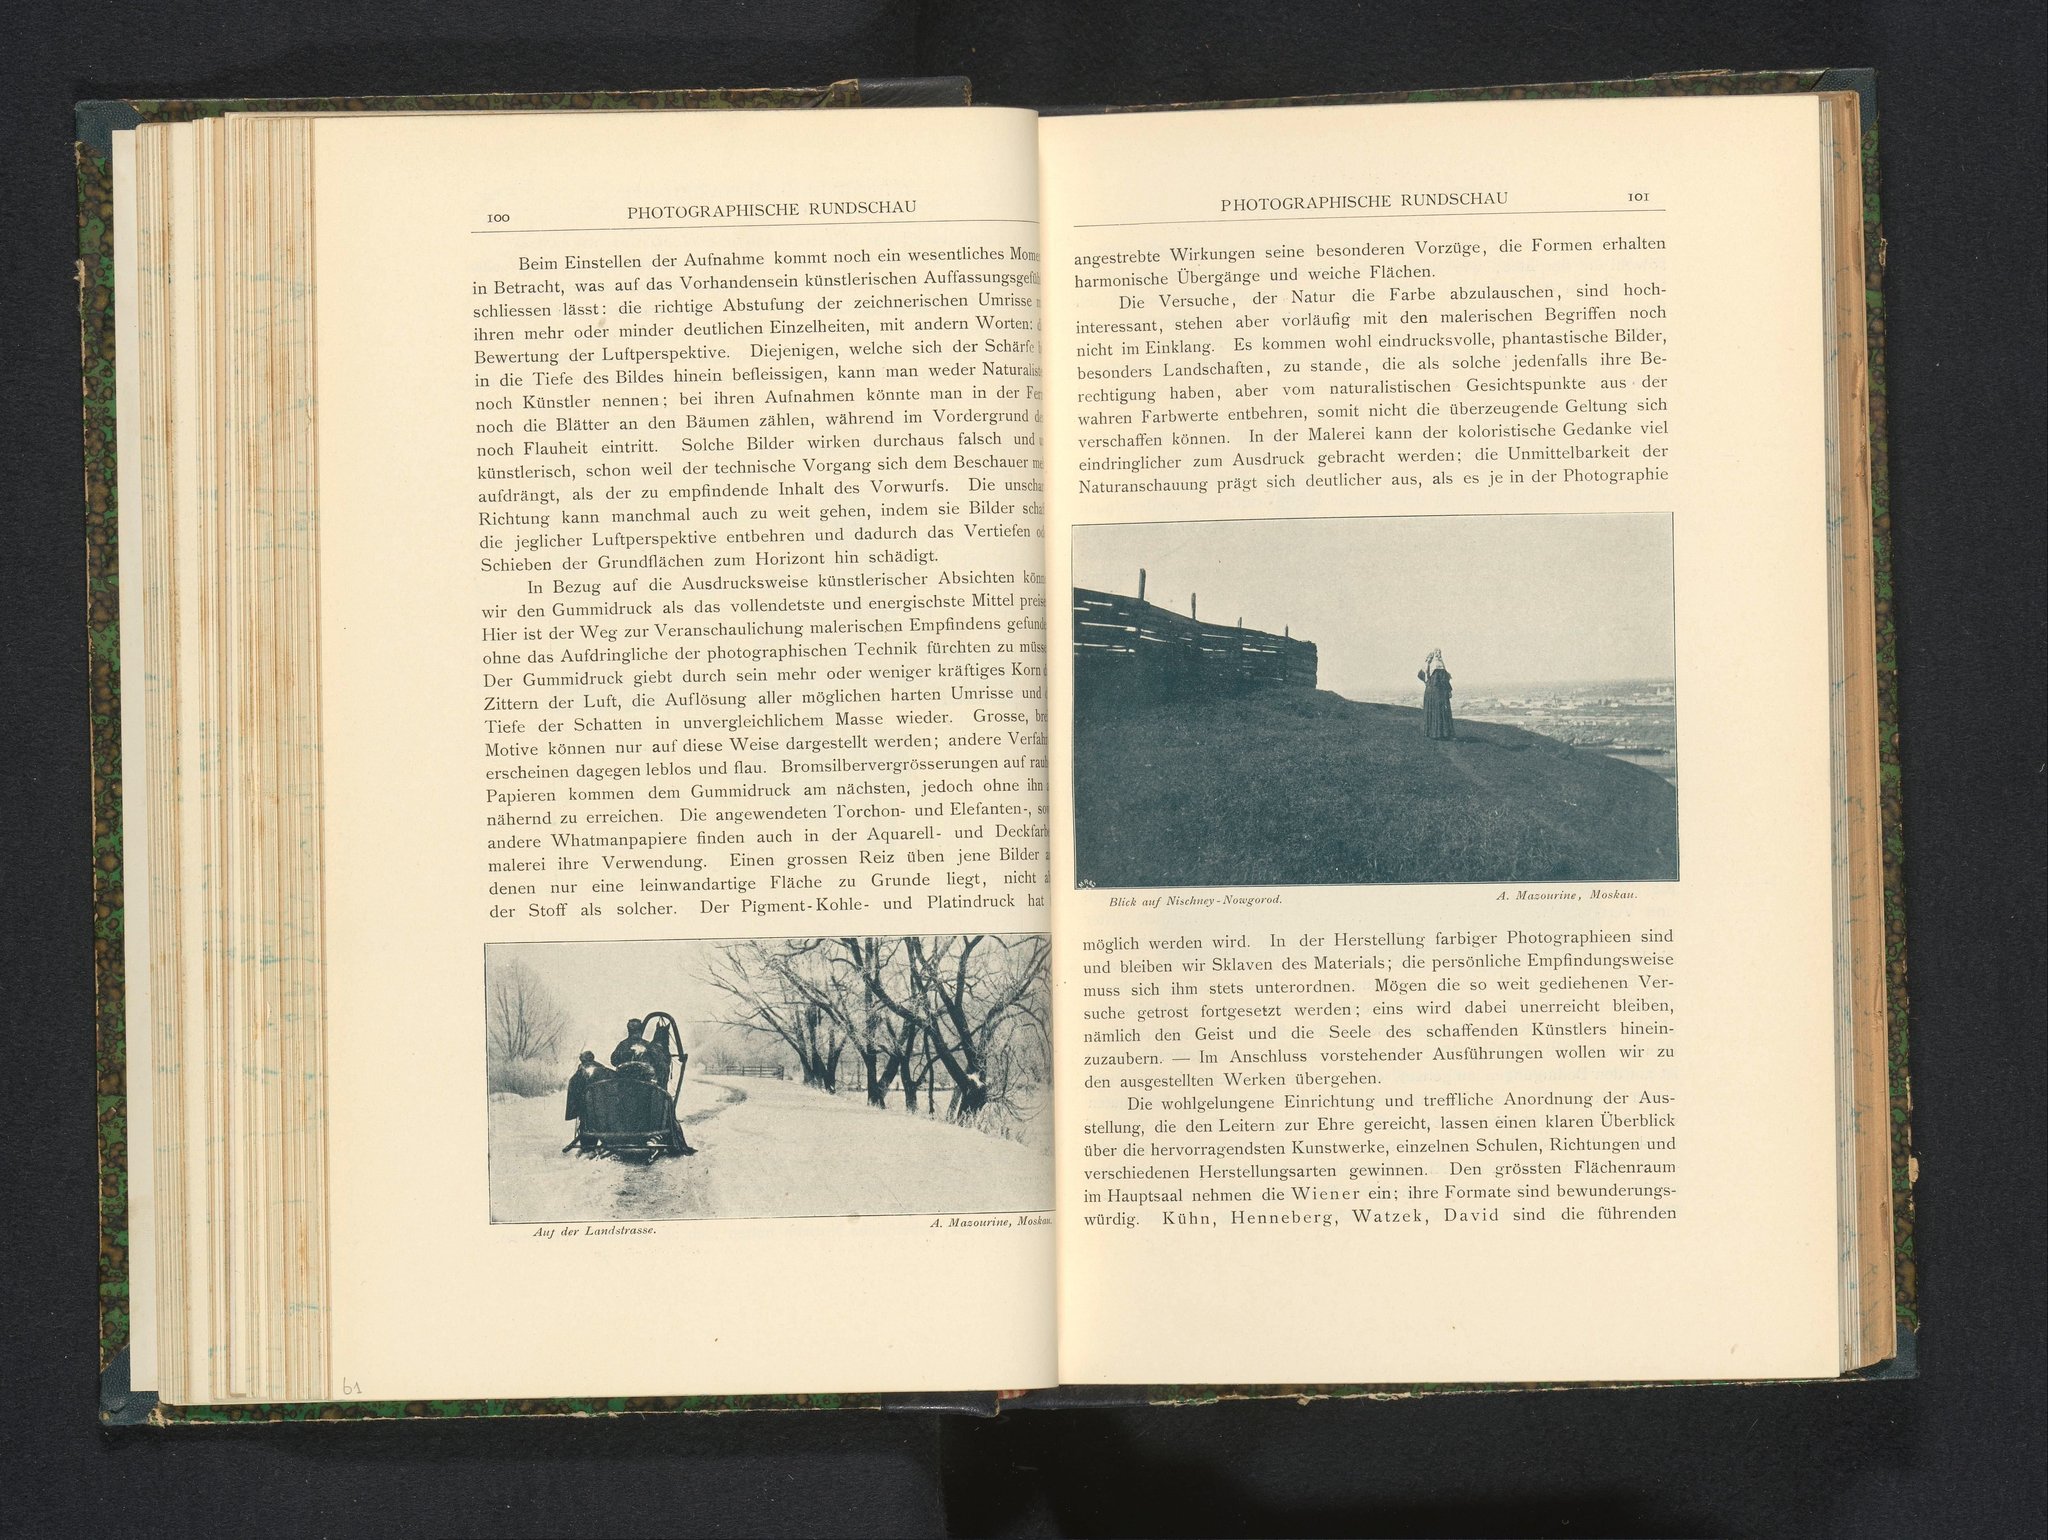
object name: page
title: Auf der Landstrasse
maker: alexis mazourine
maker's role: fotograaf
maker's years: 1846-1918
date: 1894-1899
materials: paper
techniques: autotype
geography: berlin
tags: snow, horse